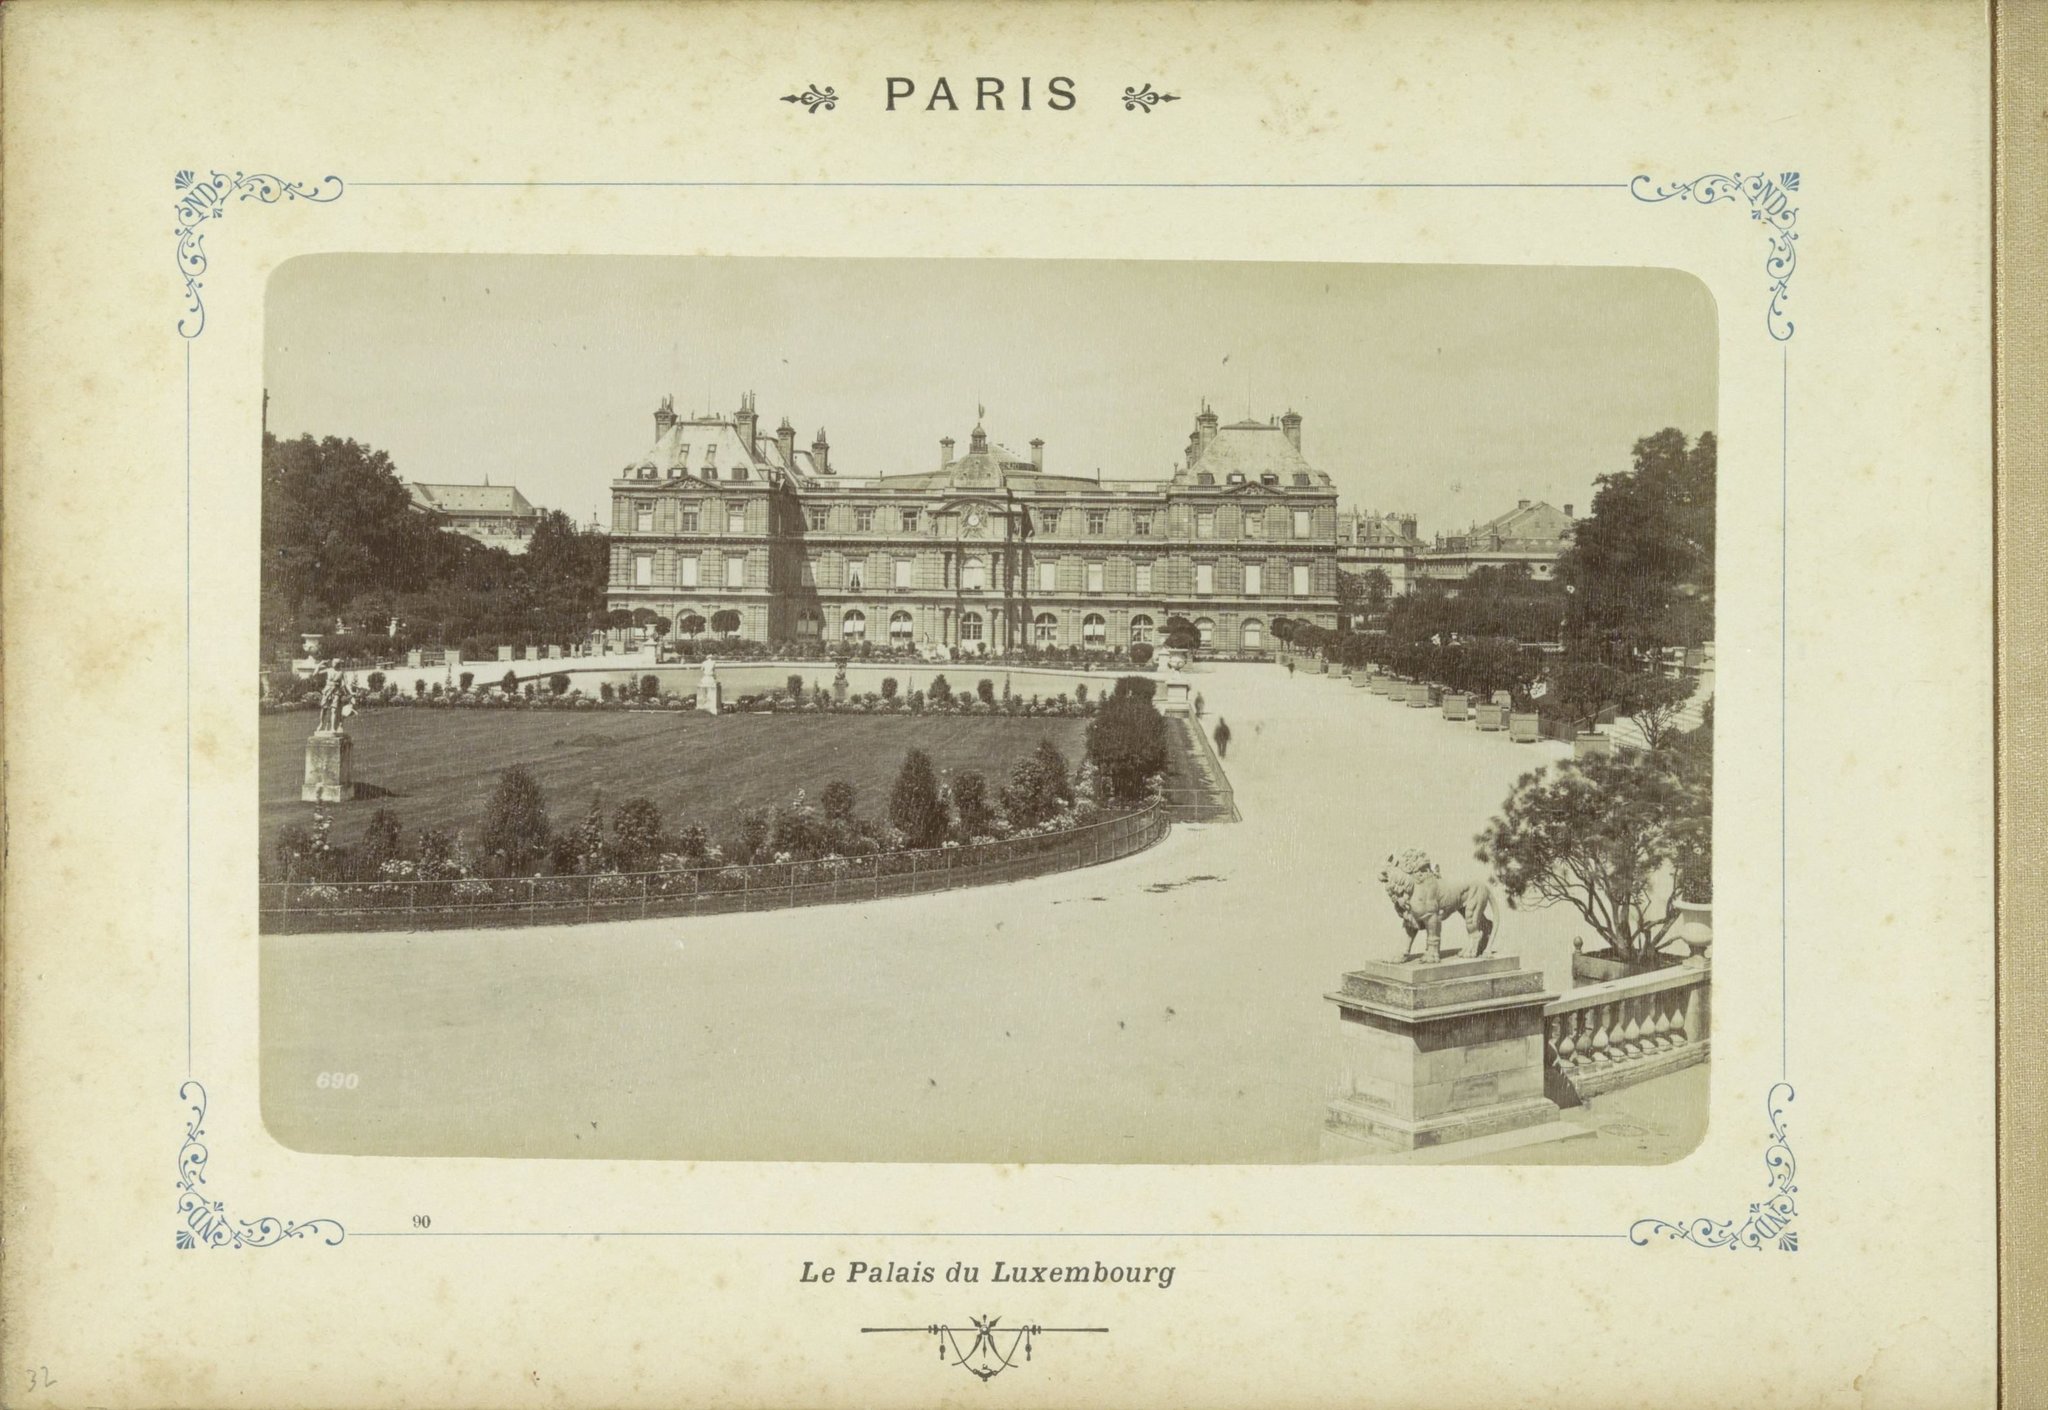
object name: photograph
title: Gezicht op het Palais du Luxembourg en tuin in Parijs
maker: Anonymous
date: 1900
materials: cardboard, paper, photographic support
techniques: albumen print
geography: paris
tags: palace, piece of sculpture, reproduction of a piece of sculpture, public gardens, park, paris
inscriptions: number: ‘690’, number: ‘90’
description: Onderdeel van Fotoalbum met bezienswaardigheden in Parijs, Versailles en het Bois de Boulogne.